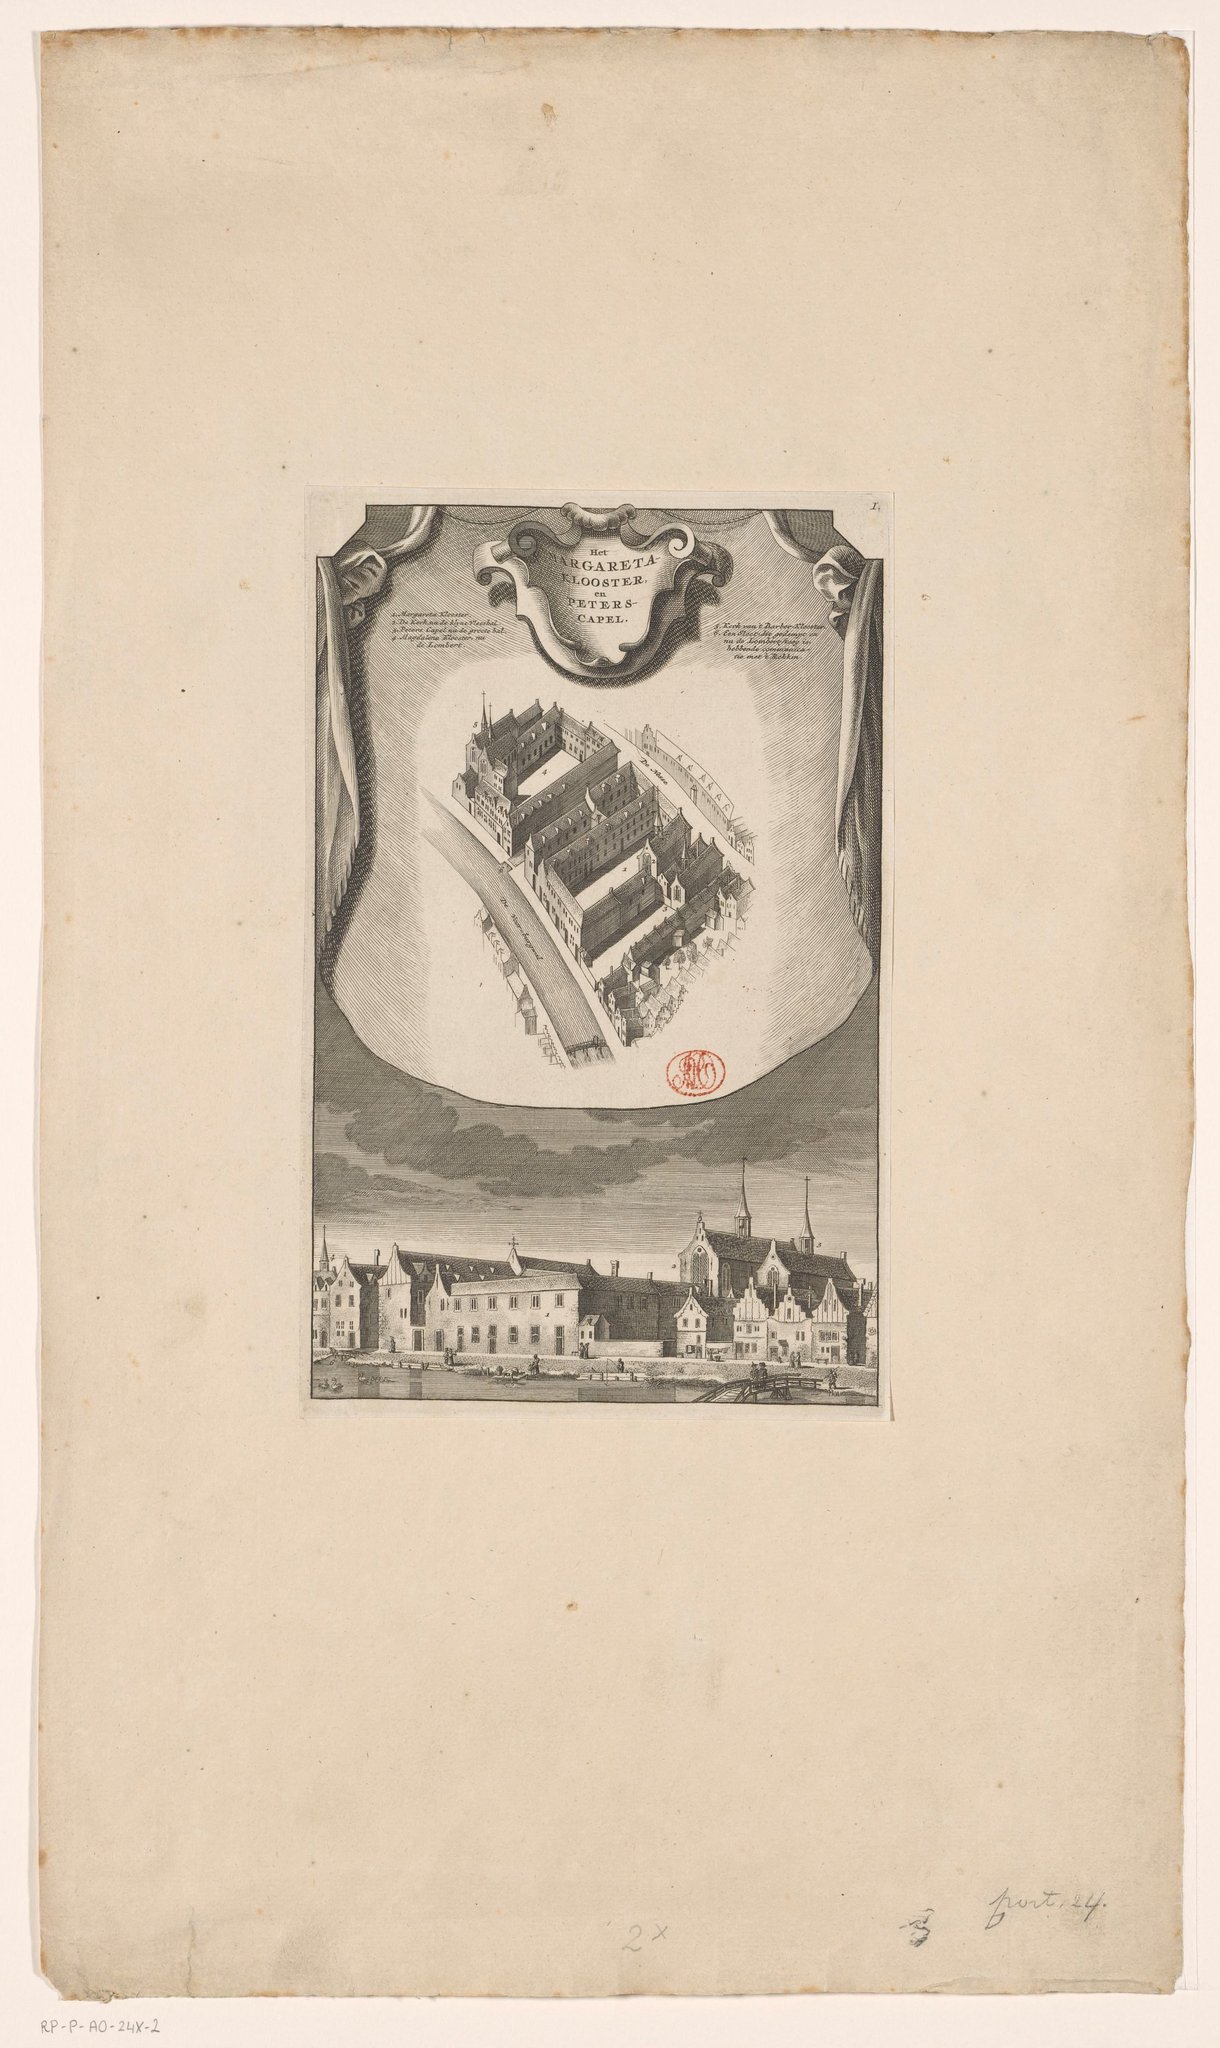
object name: book illustration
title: Het Margareta-Klooster, en Peters-Capel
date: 1760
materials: paper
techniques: engraving, etching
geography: amsterdam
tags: abbey, monastery, convent ~ roman catholic church, church (exterior) - qq - small church, chapel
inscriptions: collector's mark: Lugt 195, collector's mark: Lugt 2233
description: Prent ook gebruikt in: Wagenaar, Jan. Amsterdam, in zyne opkomst, aanwas, geschiedenissen (…). 3 delen [folio-uitgave]. Amsterdam: Isaak Tirion en Yntema & Tieboel, 1760-1767, dl. 1 (Isaac Tirion, 1760). Zie RP-P-AO-24X-3 voor proefdruk. Dat de prent de situatie rond 1544 weergeeft gaat terug op het feit dat voor het maken van deze en andere prenten van kloosters en kerken van voor de Alteratie (1578) is uitgegaan van de plattegrond van Cornelis Anthonisz. uit 1544 (zie RP-P-OB-70.399 en RP-P-AO-20-15).